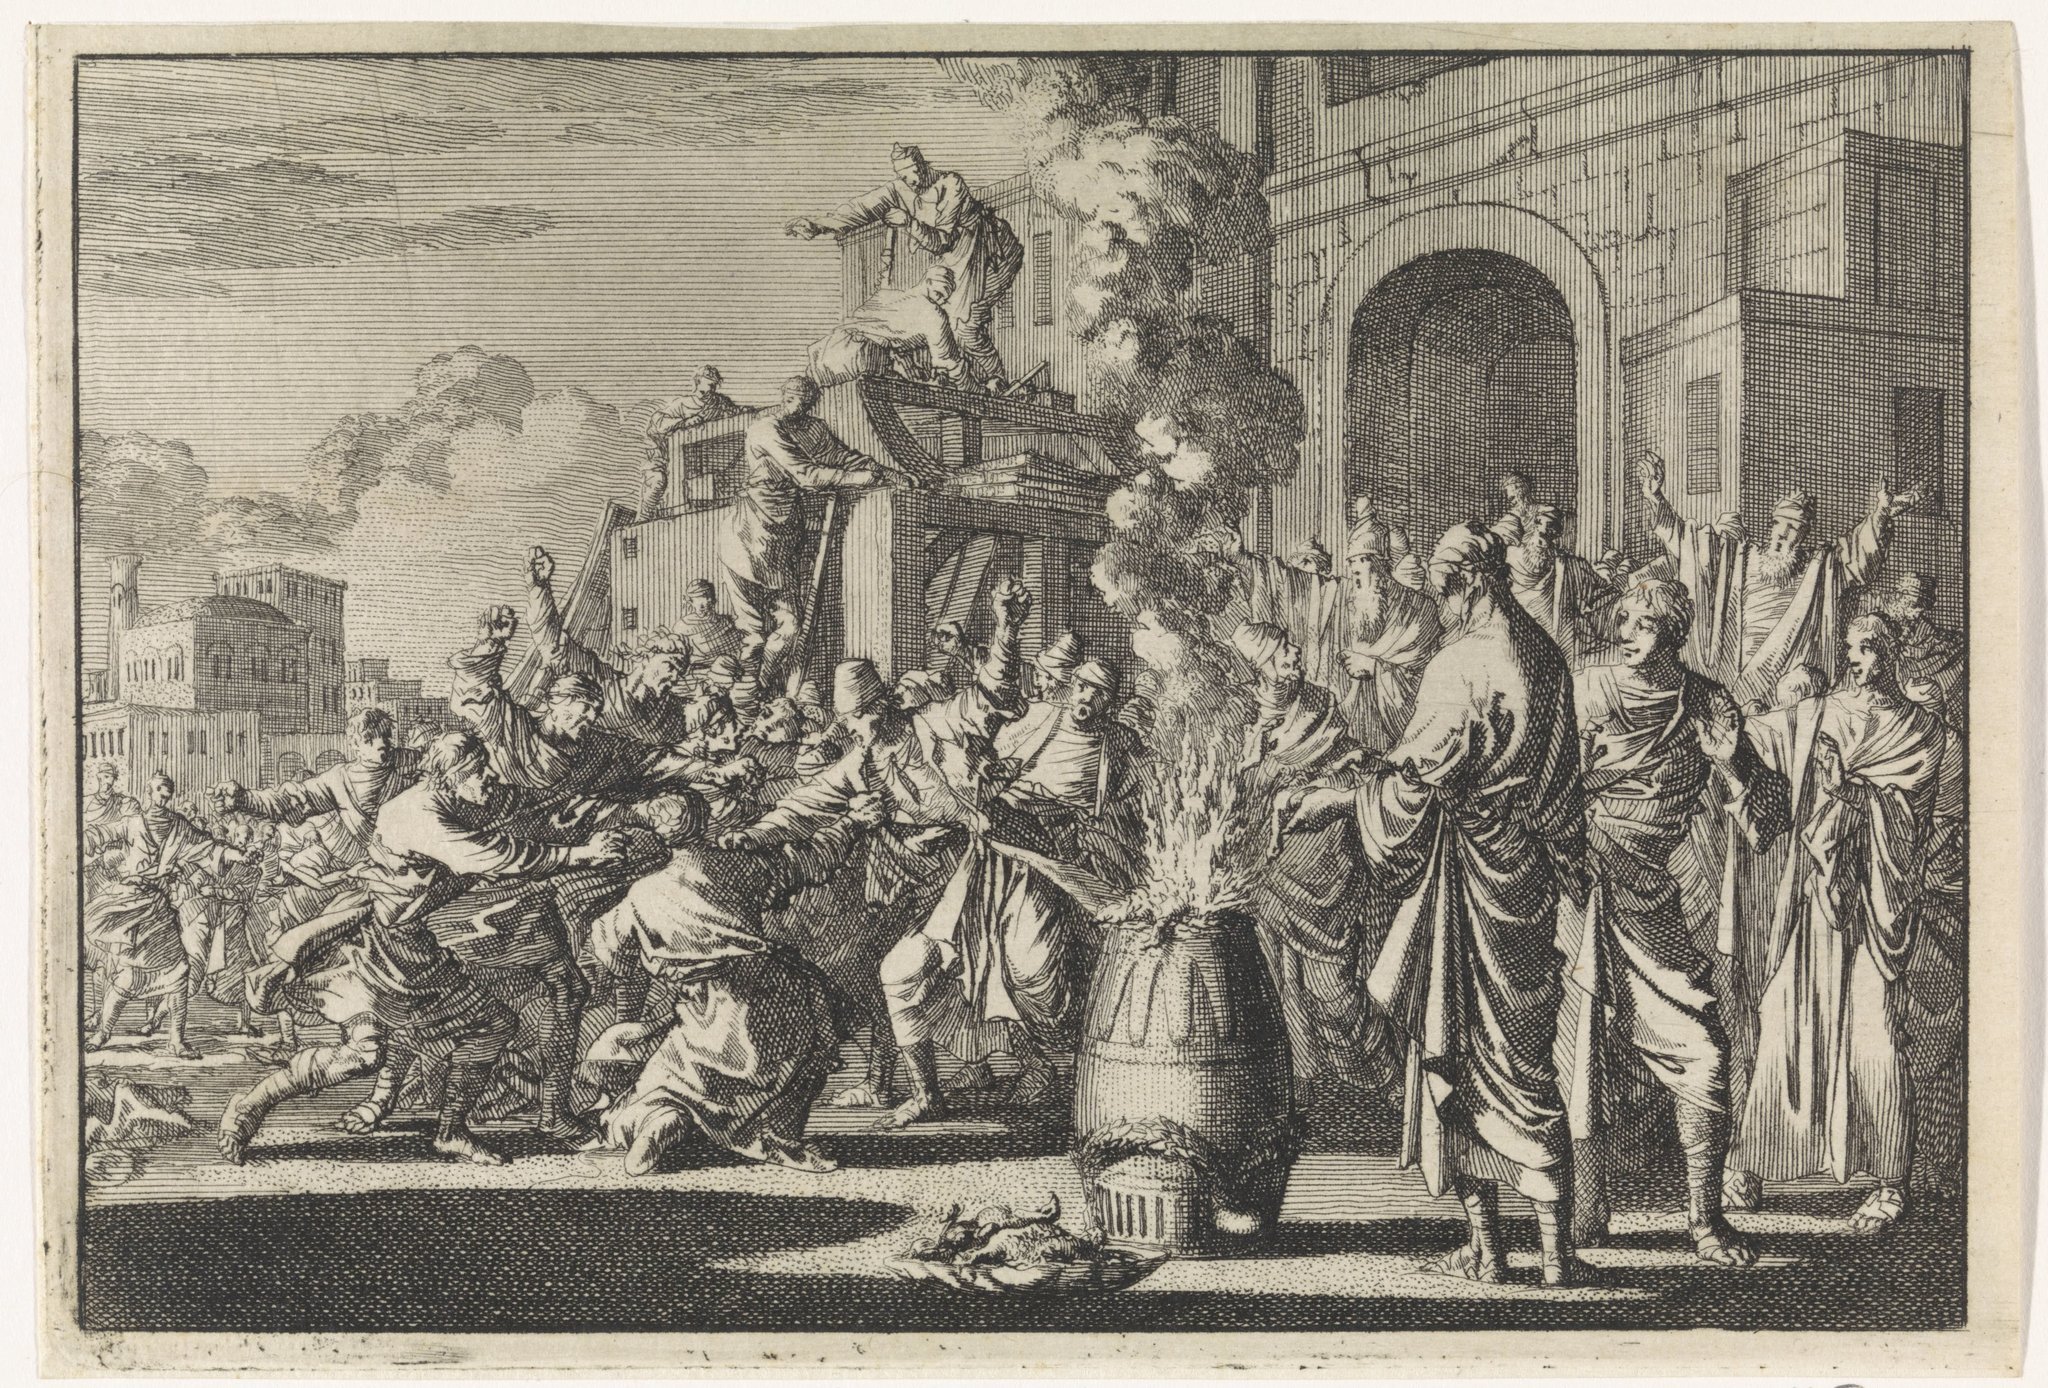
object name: print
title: Gevecht tussen Joden en Grieken voor de synagoge te Caesarea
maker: jan luyken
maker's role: draughtsman, print maker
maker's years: 1649-1712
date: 1704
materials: paper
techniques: etching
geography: amsterdam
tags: the synagogue (as building and place of worship ~ jewish religion), battle, fighting in general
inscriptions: collector's mark: Lugt 2228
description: Prent ook gebruikt als boekillustratie in: Josephus, Flavius. Alle de Werken, 2 delen. Amsterdam: Pieter Mortier, 1704, dl. 2, p. 576.